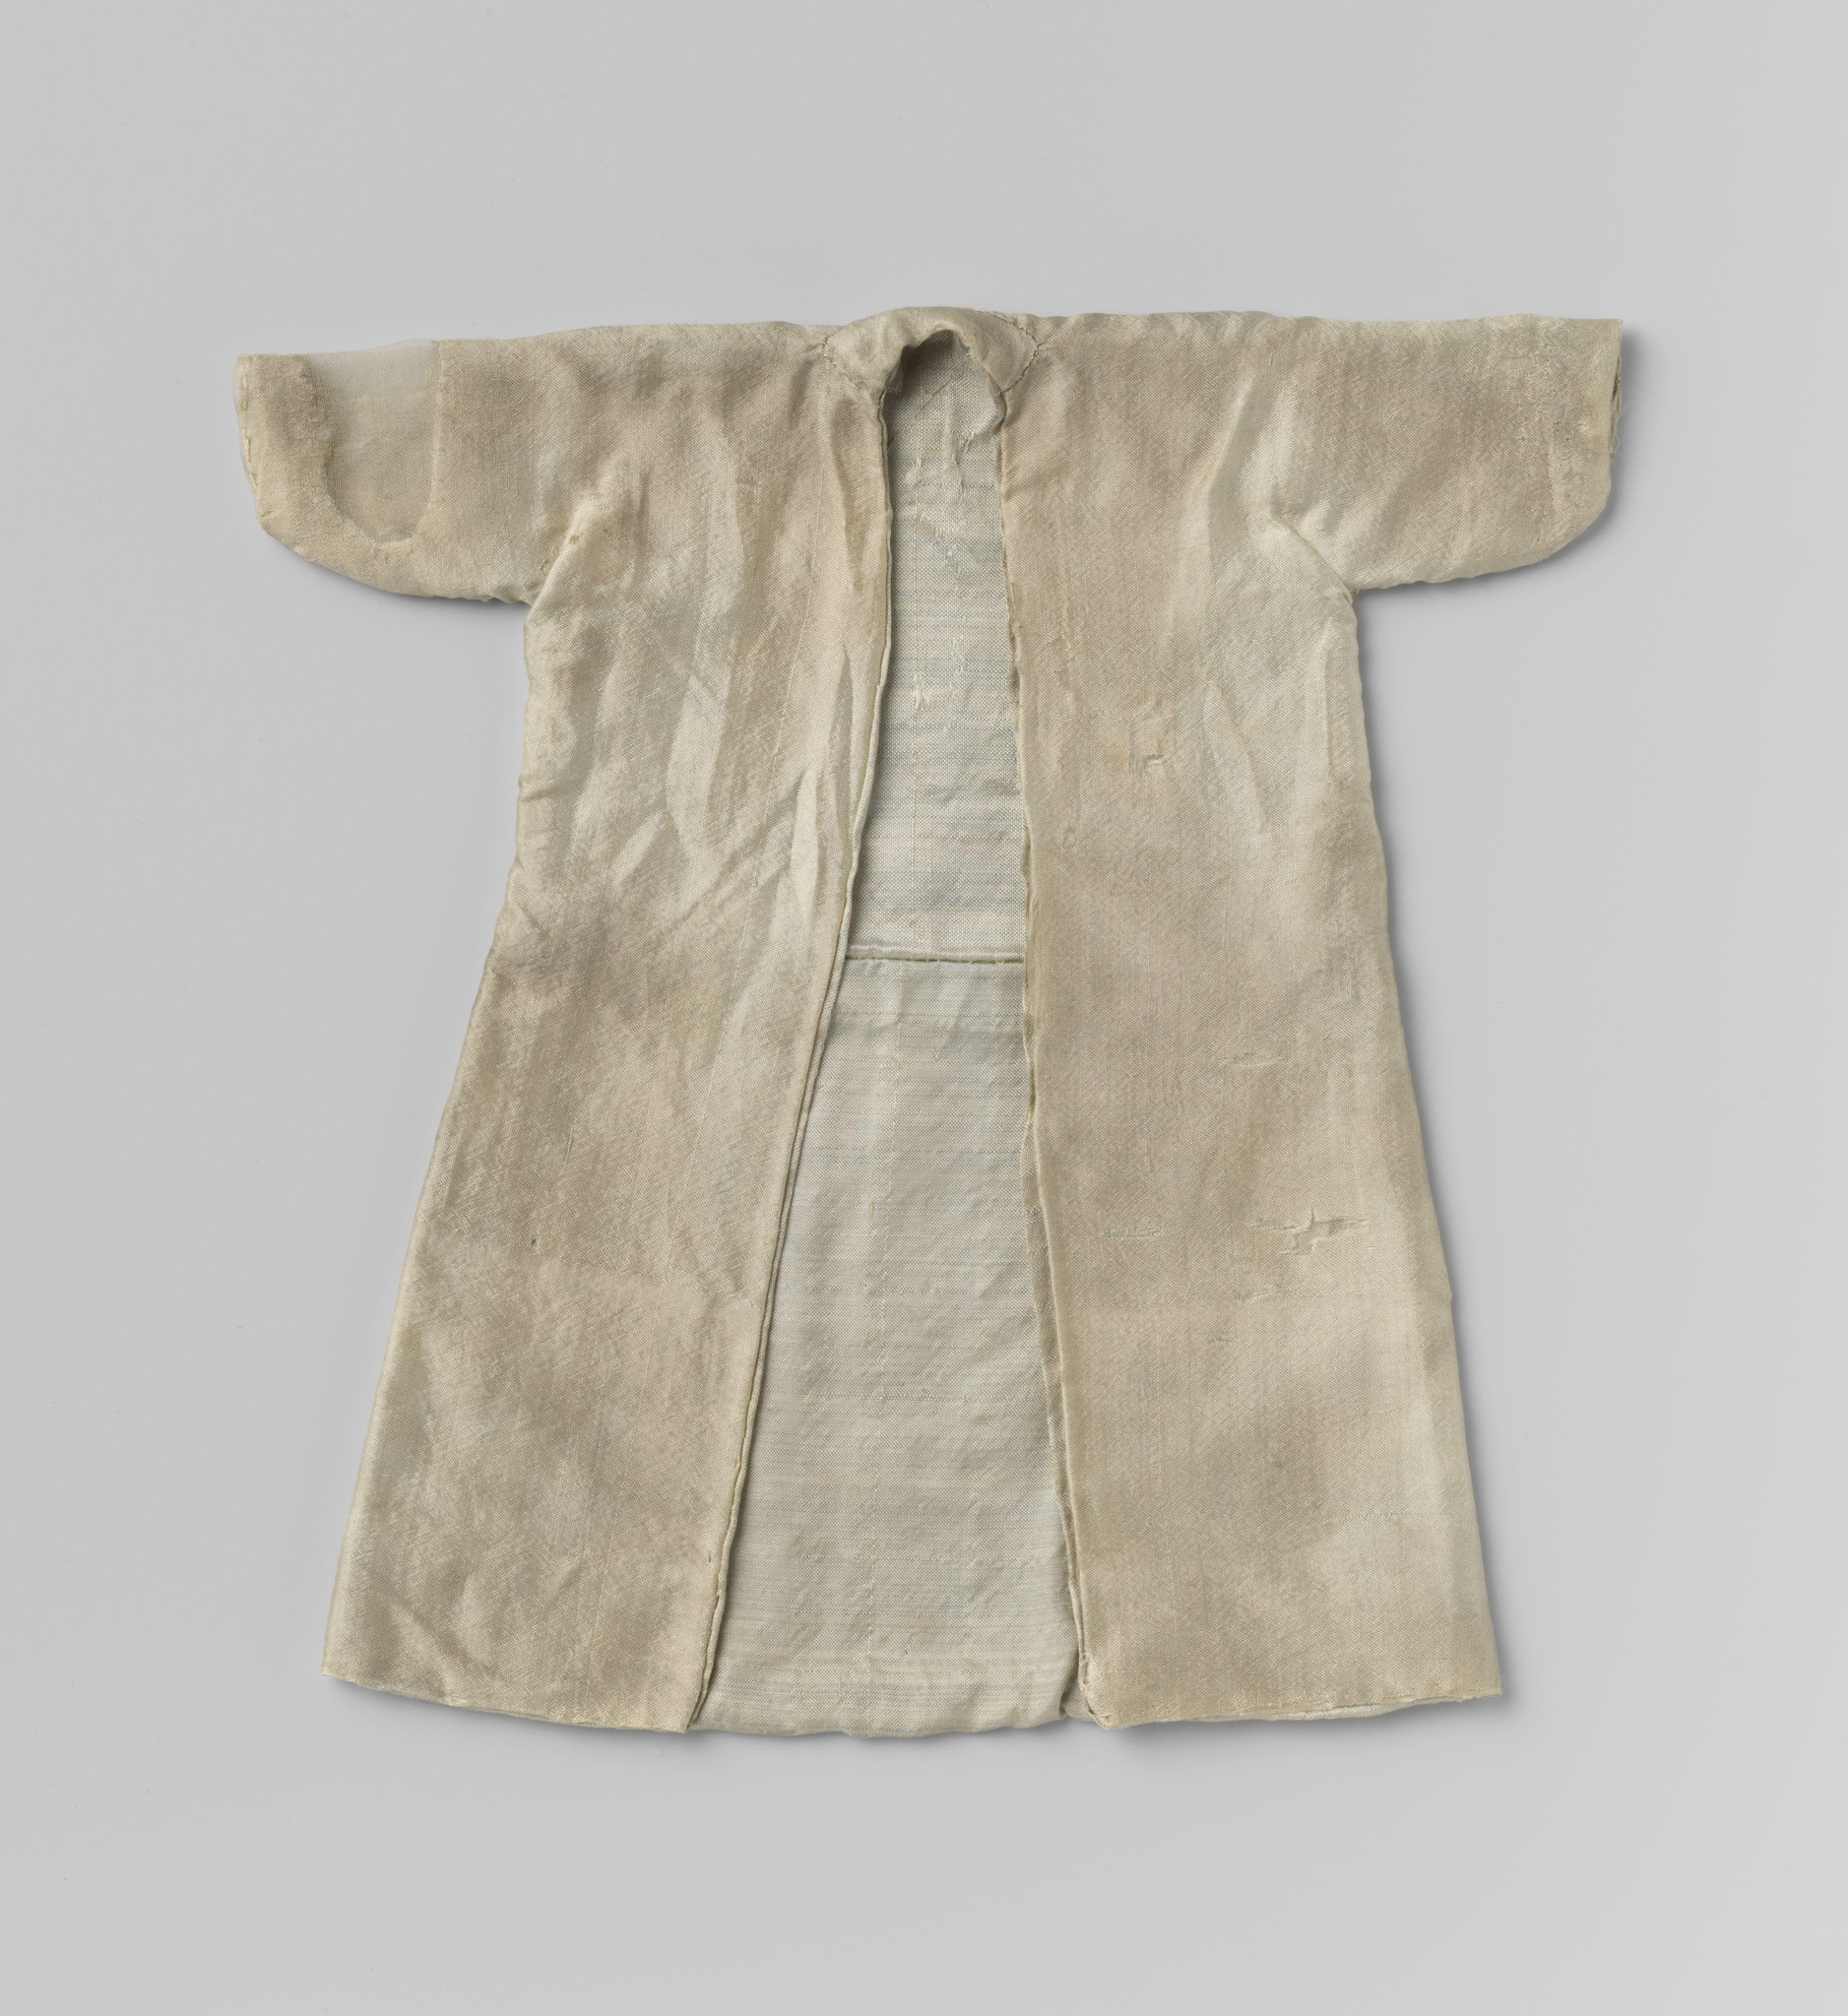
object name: banyan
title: Kamerjas van blauwe zijde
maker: Anonymous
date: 1750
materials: silk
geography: netherlands